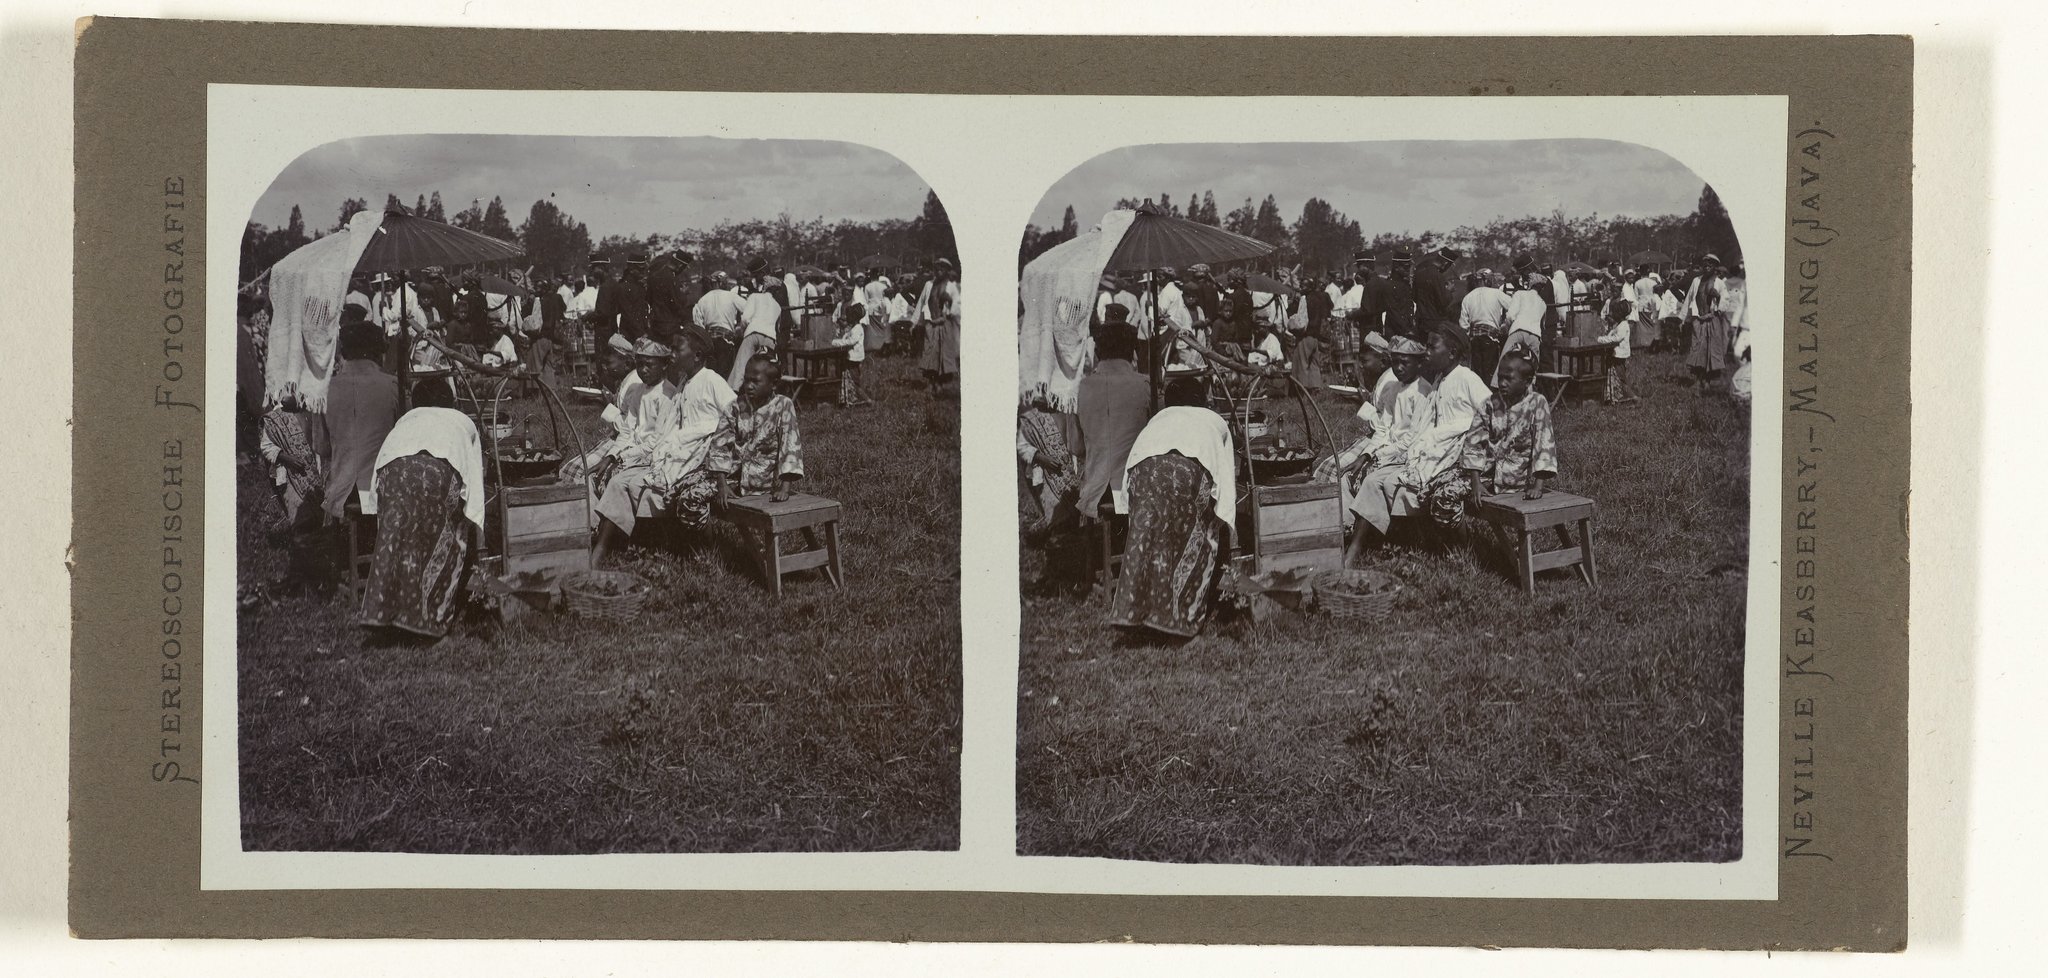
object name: stereograph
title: S 2 No 18. Openlucht restaurants.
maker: neville keasberry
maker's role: fotograaf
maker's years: 1866-1944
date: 1900-1935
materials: cardboard, paper, photographic support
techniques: albumen print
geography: malang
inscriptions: signature: ‘Neville Keasberry, Malang (Java)’, inscription: ‘Stereoscopische Fotografie’, title: ‘S 2 No 18. Openlucht restaurants.’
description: Javaanse eettentjes in de buitenlucht op een druk bezocht terrein.